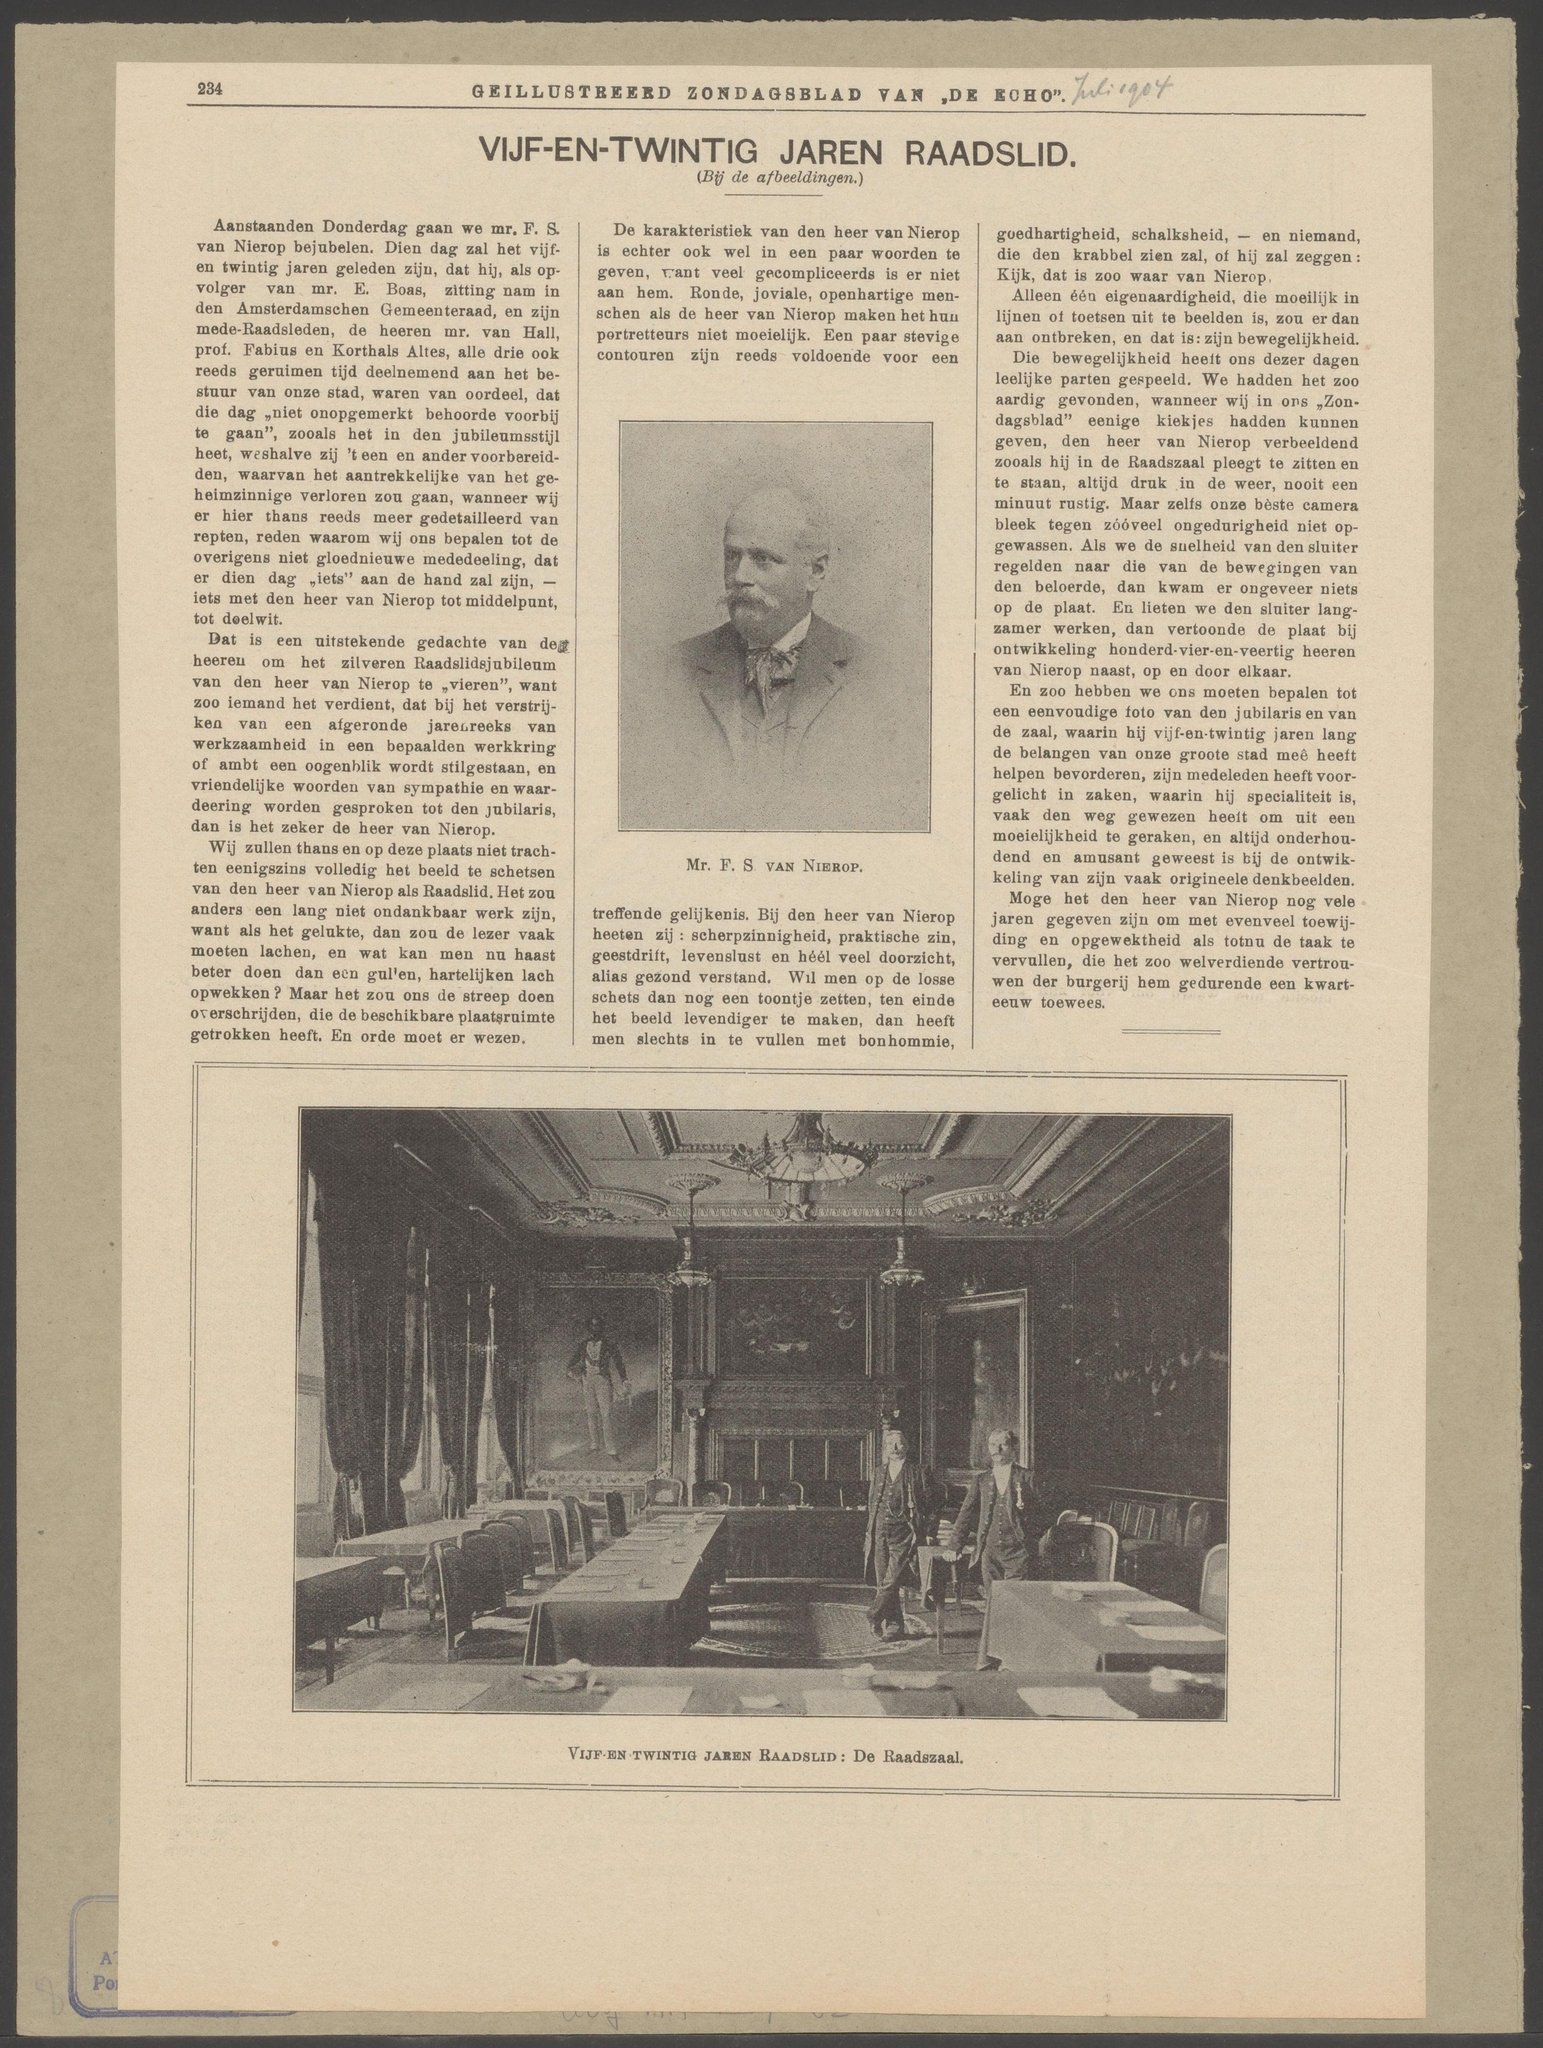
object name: text sheet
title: Aankondiging van 25-jarig jubileum van Frederik Salomon van Nierop als gemeenteraadslid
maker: Anonymous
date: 1904-1907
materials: paper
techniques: letterpress printing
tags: historical persons, politician, e.g. party leader, amsterdam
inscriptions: collector's mark: ‘19,82’ Lugt 1641b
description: Onderwerpsrubriek binnen de Atlas Amsterdam: Herinneringen aan regeringsleden en hunne huisgezinnen [na 1800].